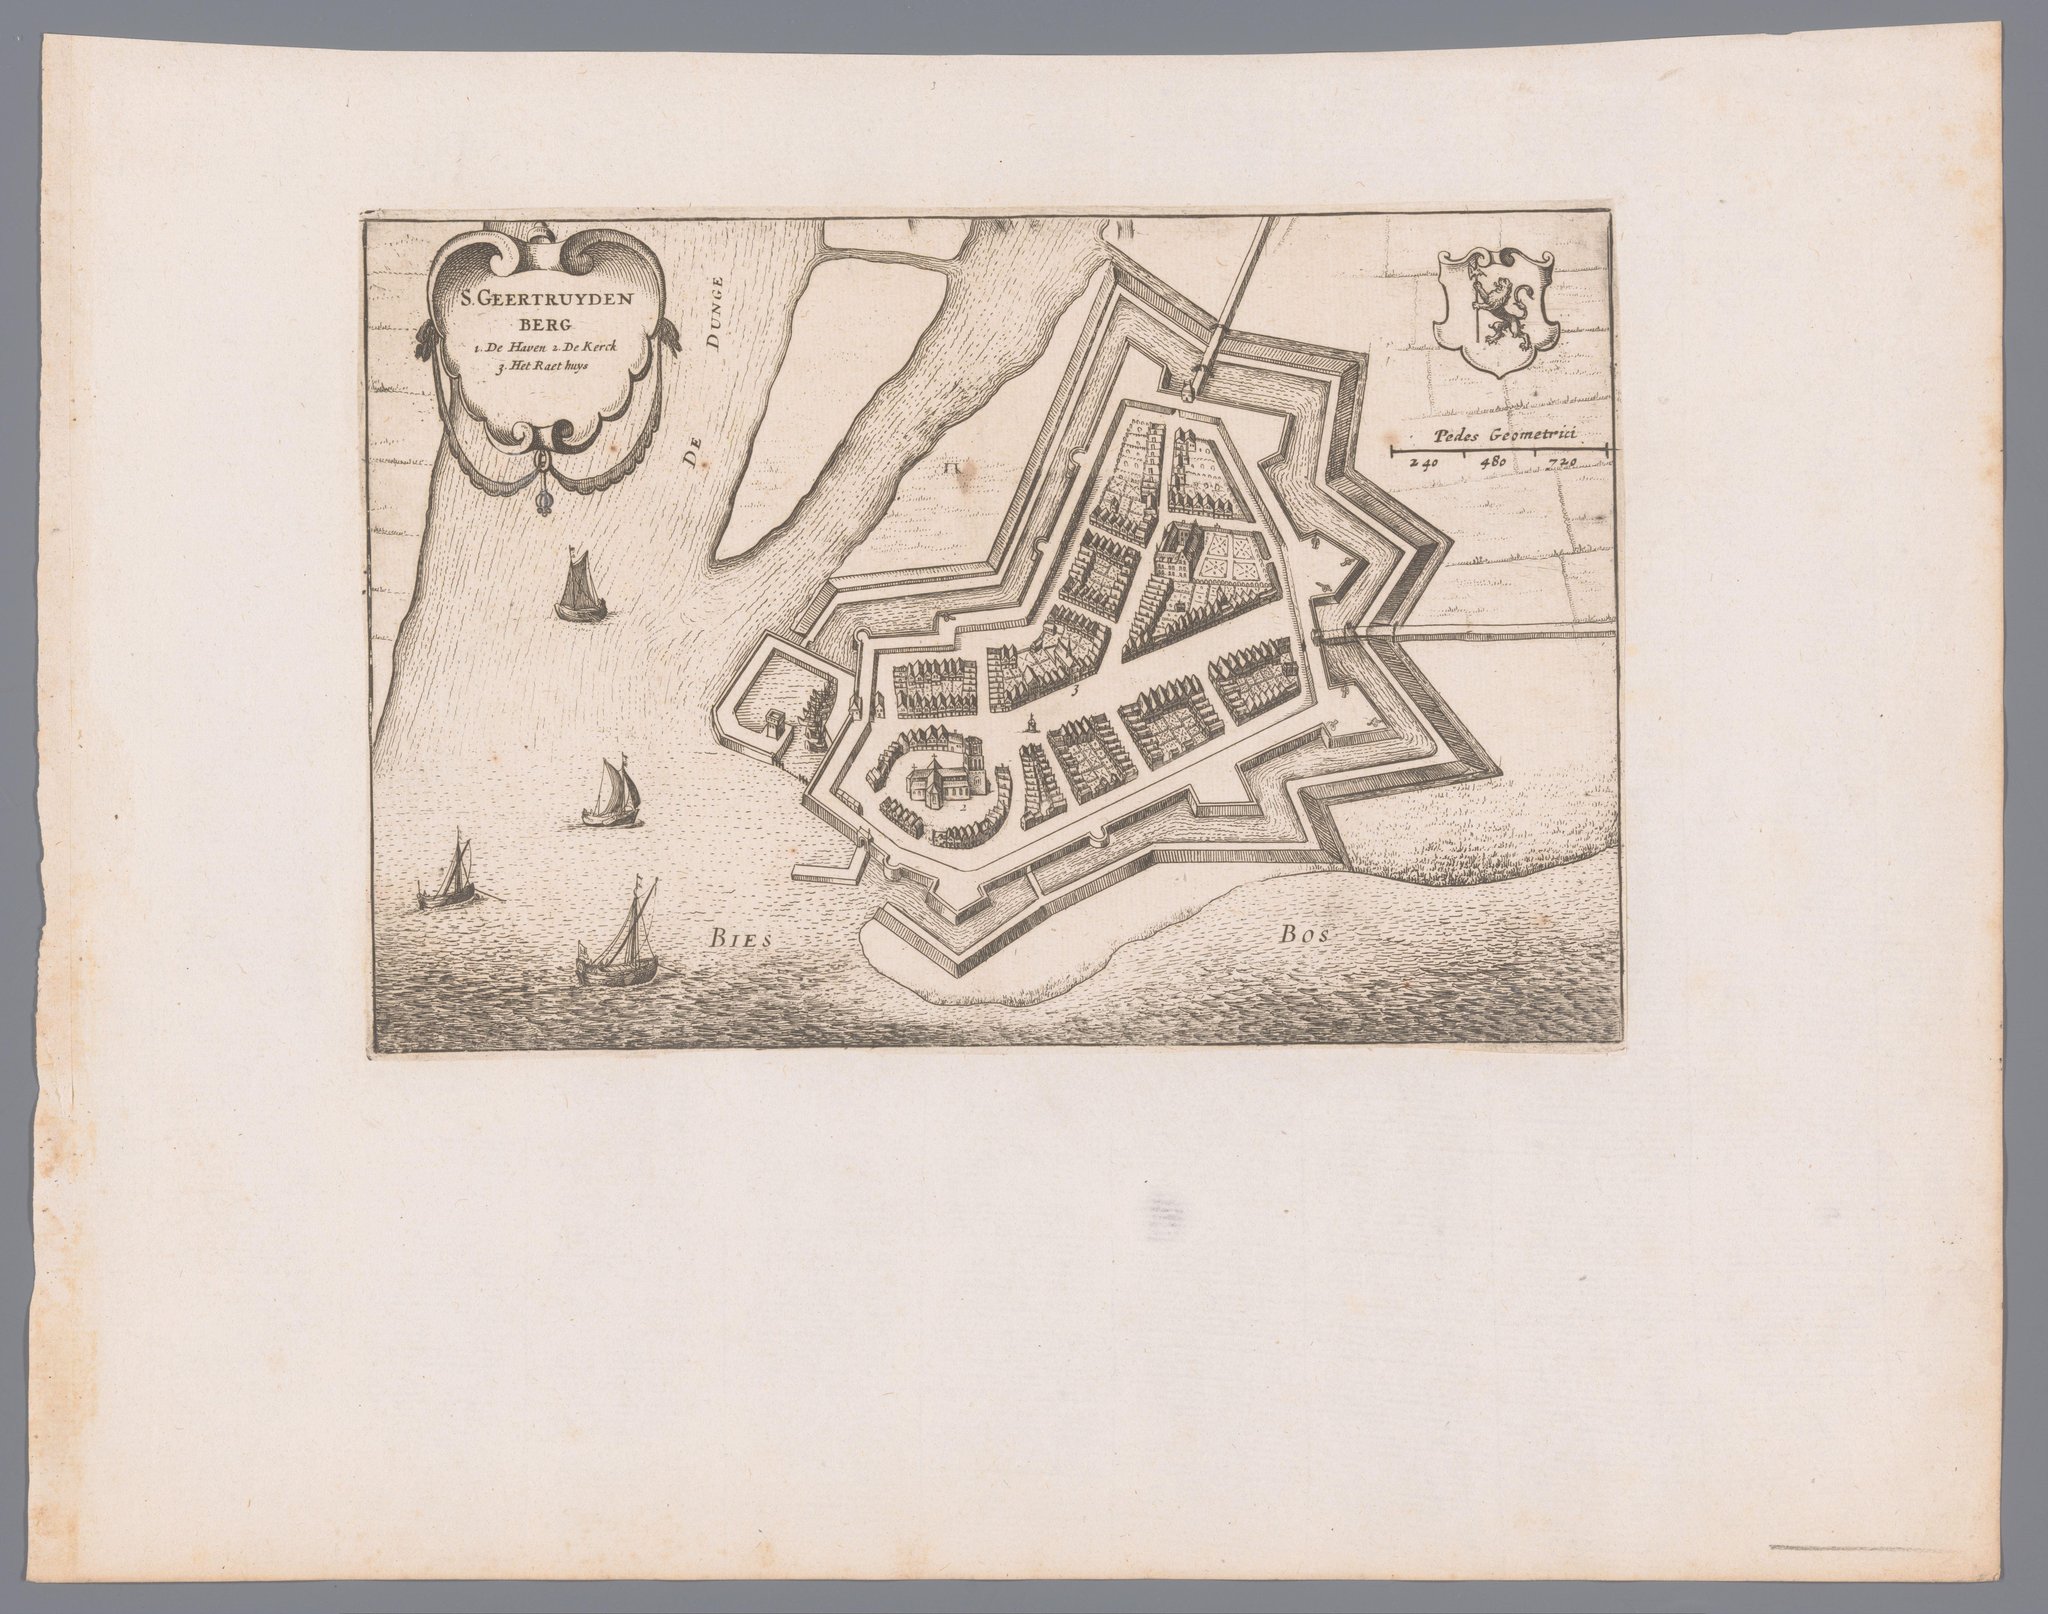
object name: print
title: Plattegrond van Geertruidenberg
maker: Anonymous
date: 1632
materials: paper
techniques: etching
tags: maps of cities, geertruidenberg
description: Prent uit: Boxhorn, Marcus Zuerii. Theatrum sive Hollandiae comitatus et urbium nova descriptio (...). Amsterdam: Henricus Hondius, 1632. Daarna is deze plattegrond gebruikt in een aantal edities van Joan Blaeu's 'Toonneel der steden van de Vereenighde Nederlanden', 1649-1652. Zie Koeman, 2010 voor details.